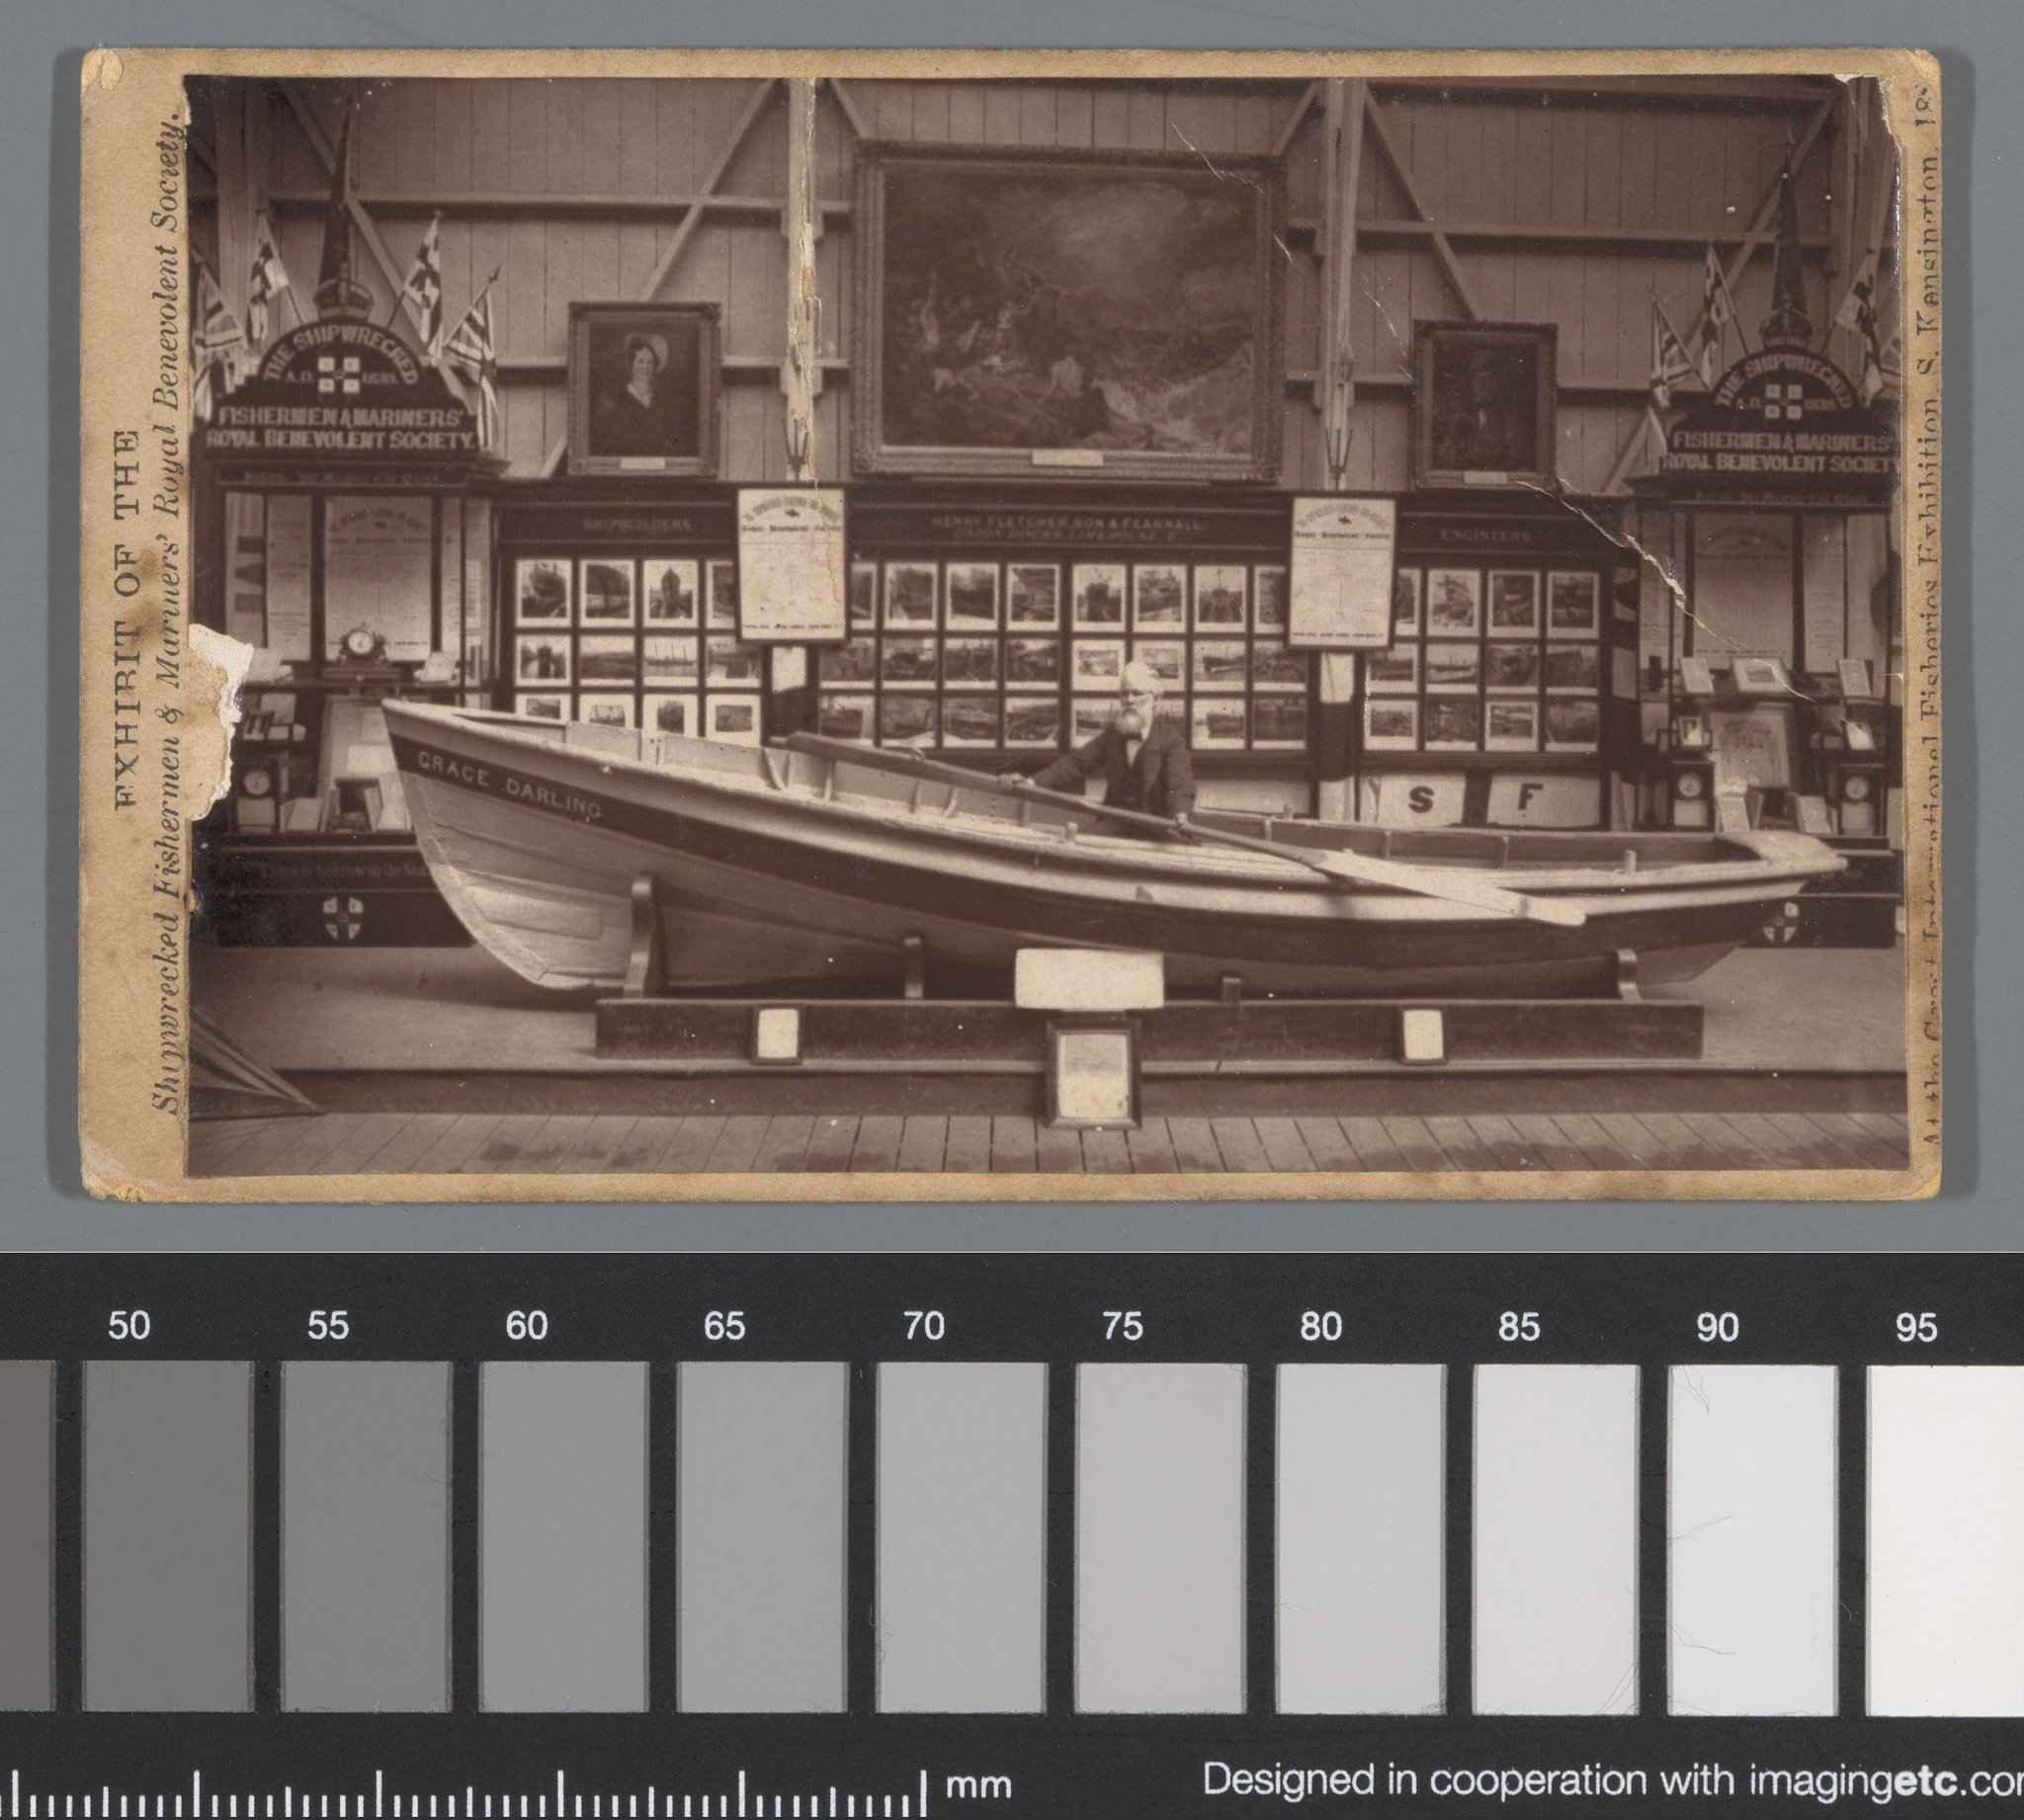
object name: photograph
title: Exhibit of the Shipwrecked Fishermen & Mariners' Royal Benevolent Society. At the Great International Fisheries Exhibition, S. Kensington, 1883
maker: Anonymous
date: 1883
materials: cardboard, paper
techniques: albumen print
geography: london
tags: trade exhibition, industries fair, rowing-boat, canoe, etc.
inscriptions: inscription: ‘(Kindly lent by Mrs. JOHN JOICEY.)/ Exhibited by "The Shpwrecked Fishermen & Mariners' Royal Benevolent Society."/ Extracted from a leading article in "The Daily Telegraph."/ (...)’, copyright notice: ‘LONDON STEREOSCOPIC CO. COPYRIGHT.’